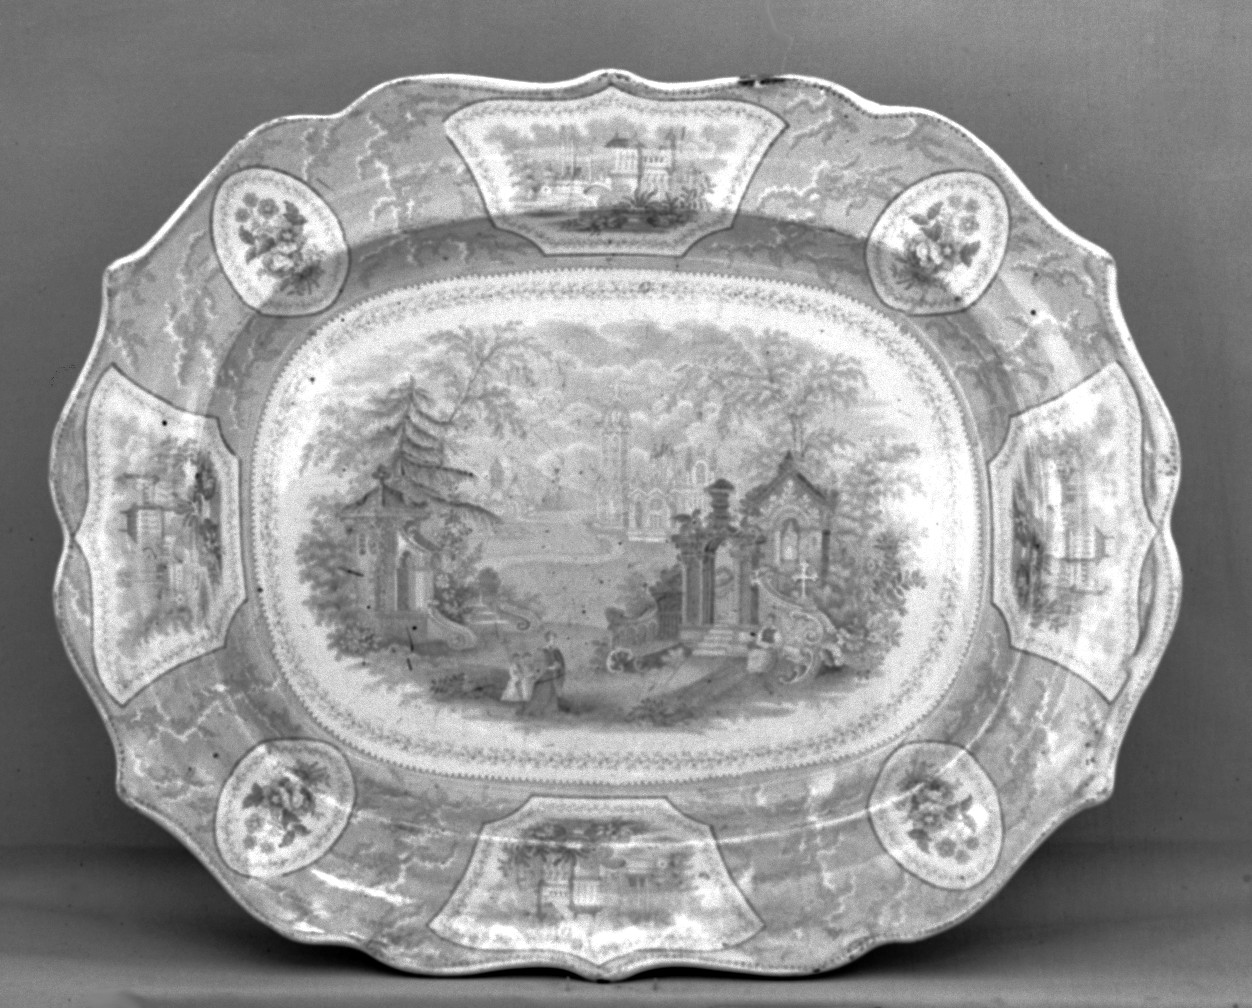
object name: platter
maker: j. and j. jackson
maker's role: factory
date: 1831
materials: pottery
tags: buildings,flowers,trees